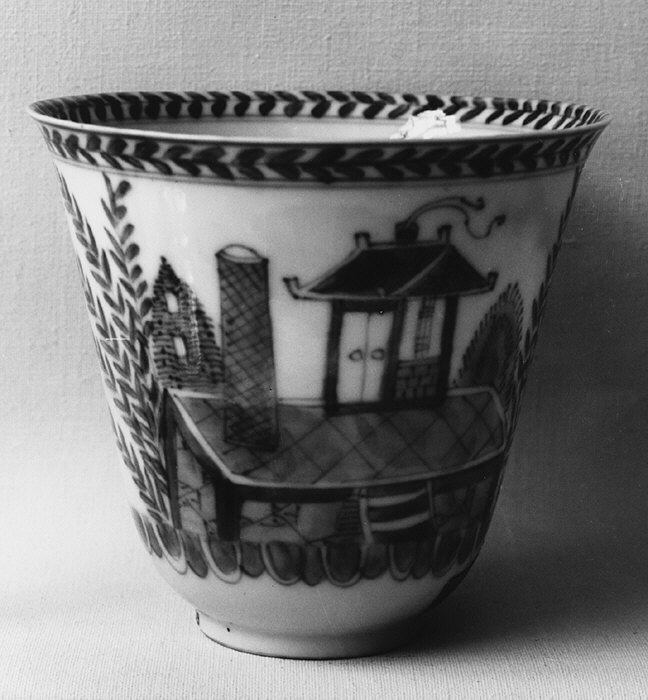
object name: beaker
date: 1710-1730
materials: hard paste porcelain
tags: houses